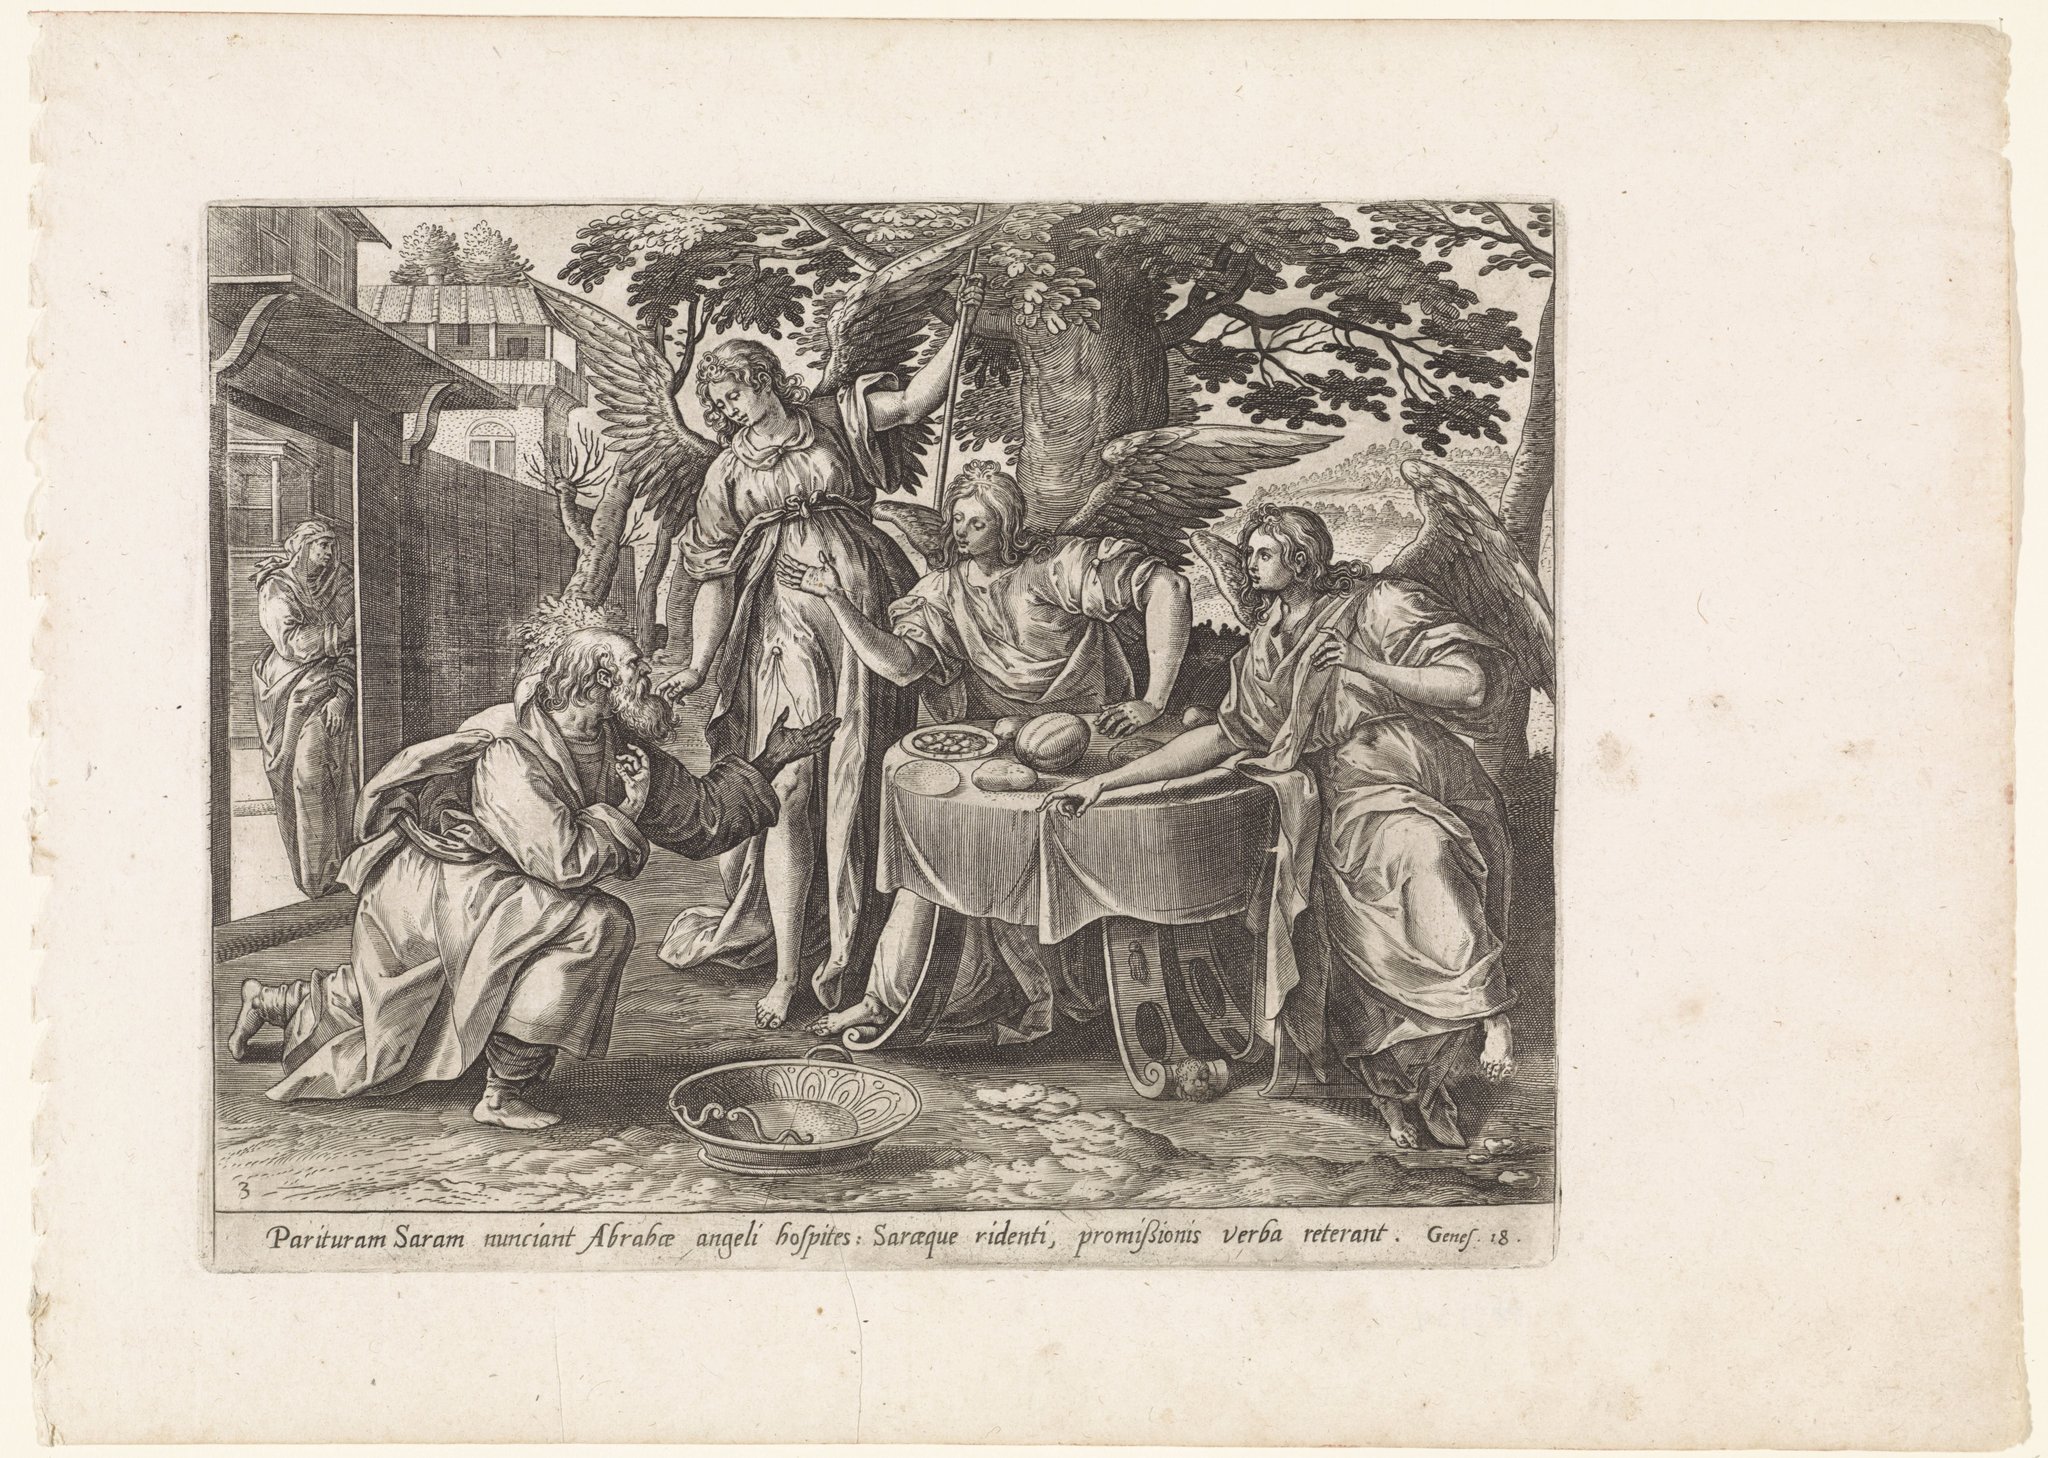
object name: print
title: Abraham en de drie engelen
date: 1585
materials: paper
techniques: engraving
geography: antwerp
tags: the promise of a son is renewed; sarah, overhearing it, laughs incredulously, abraham kneels before the angels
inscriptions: collector's mark: Lugt 2760, collector's mark: Lugt 2228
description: De drie engelen bezoeken Abraham en zitten aan de tafel, die hij voor hen heeft gedekt. Zij beloven hem dat hij en Sara een zoon zullen krijgen. Abraham hoort het nieuws geknield aan. Sara luistert in de deuropening mee. Onder de voorstelling een verwijzing in het Latijn naar de Bijbeltekst in Gen. 18.